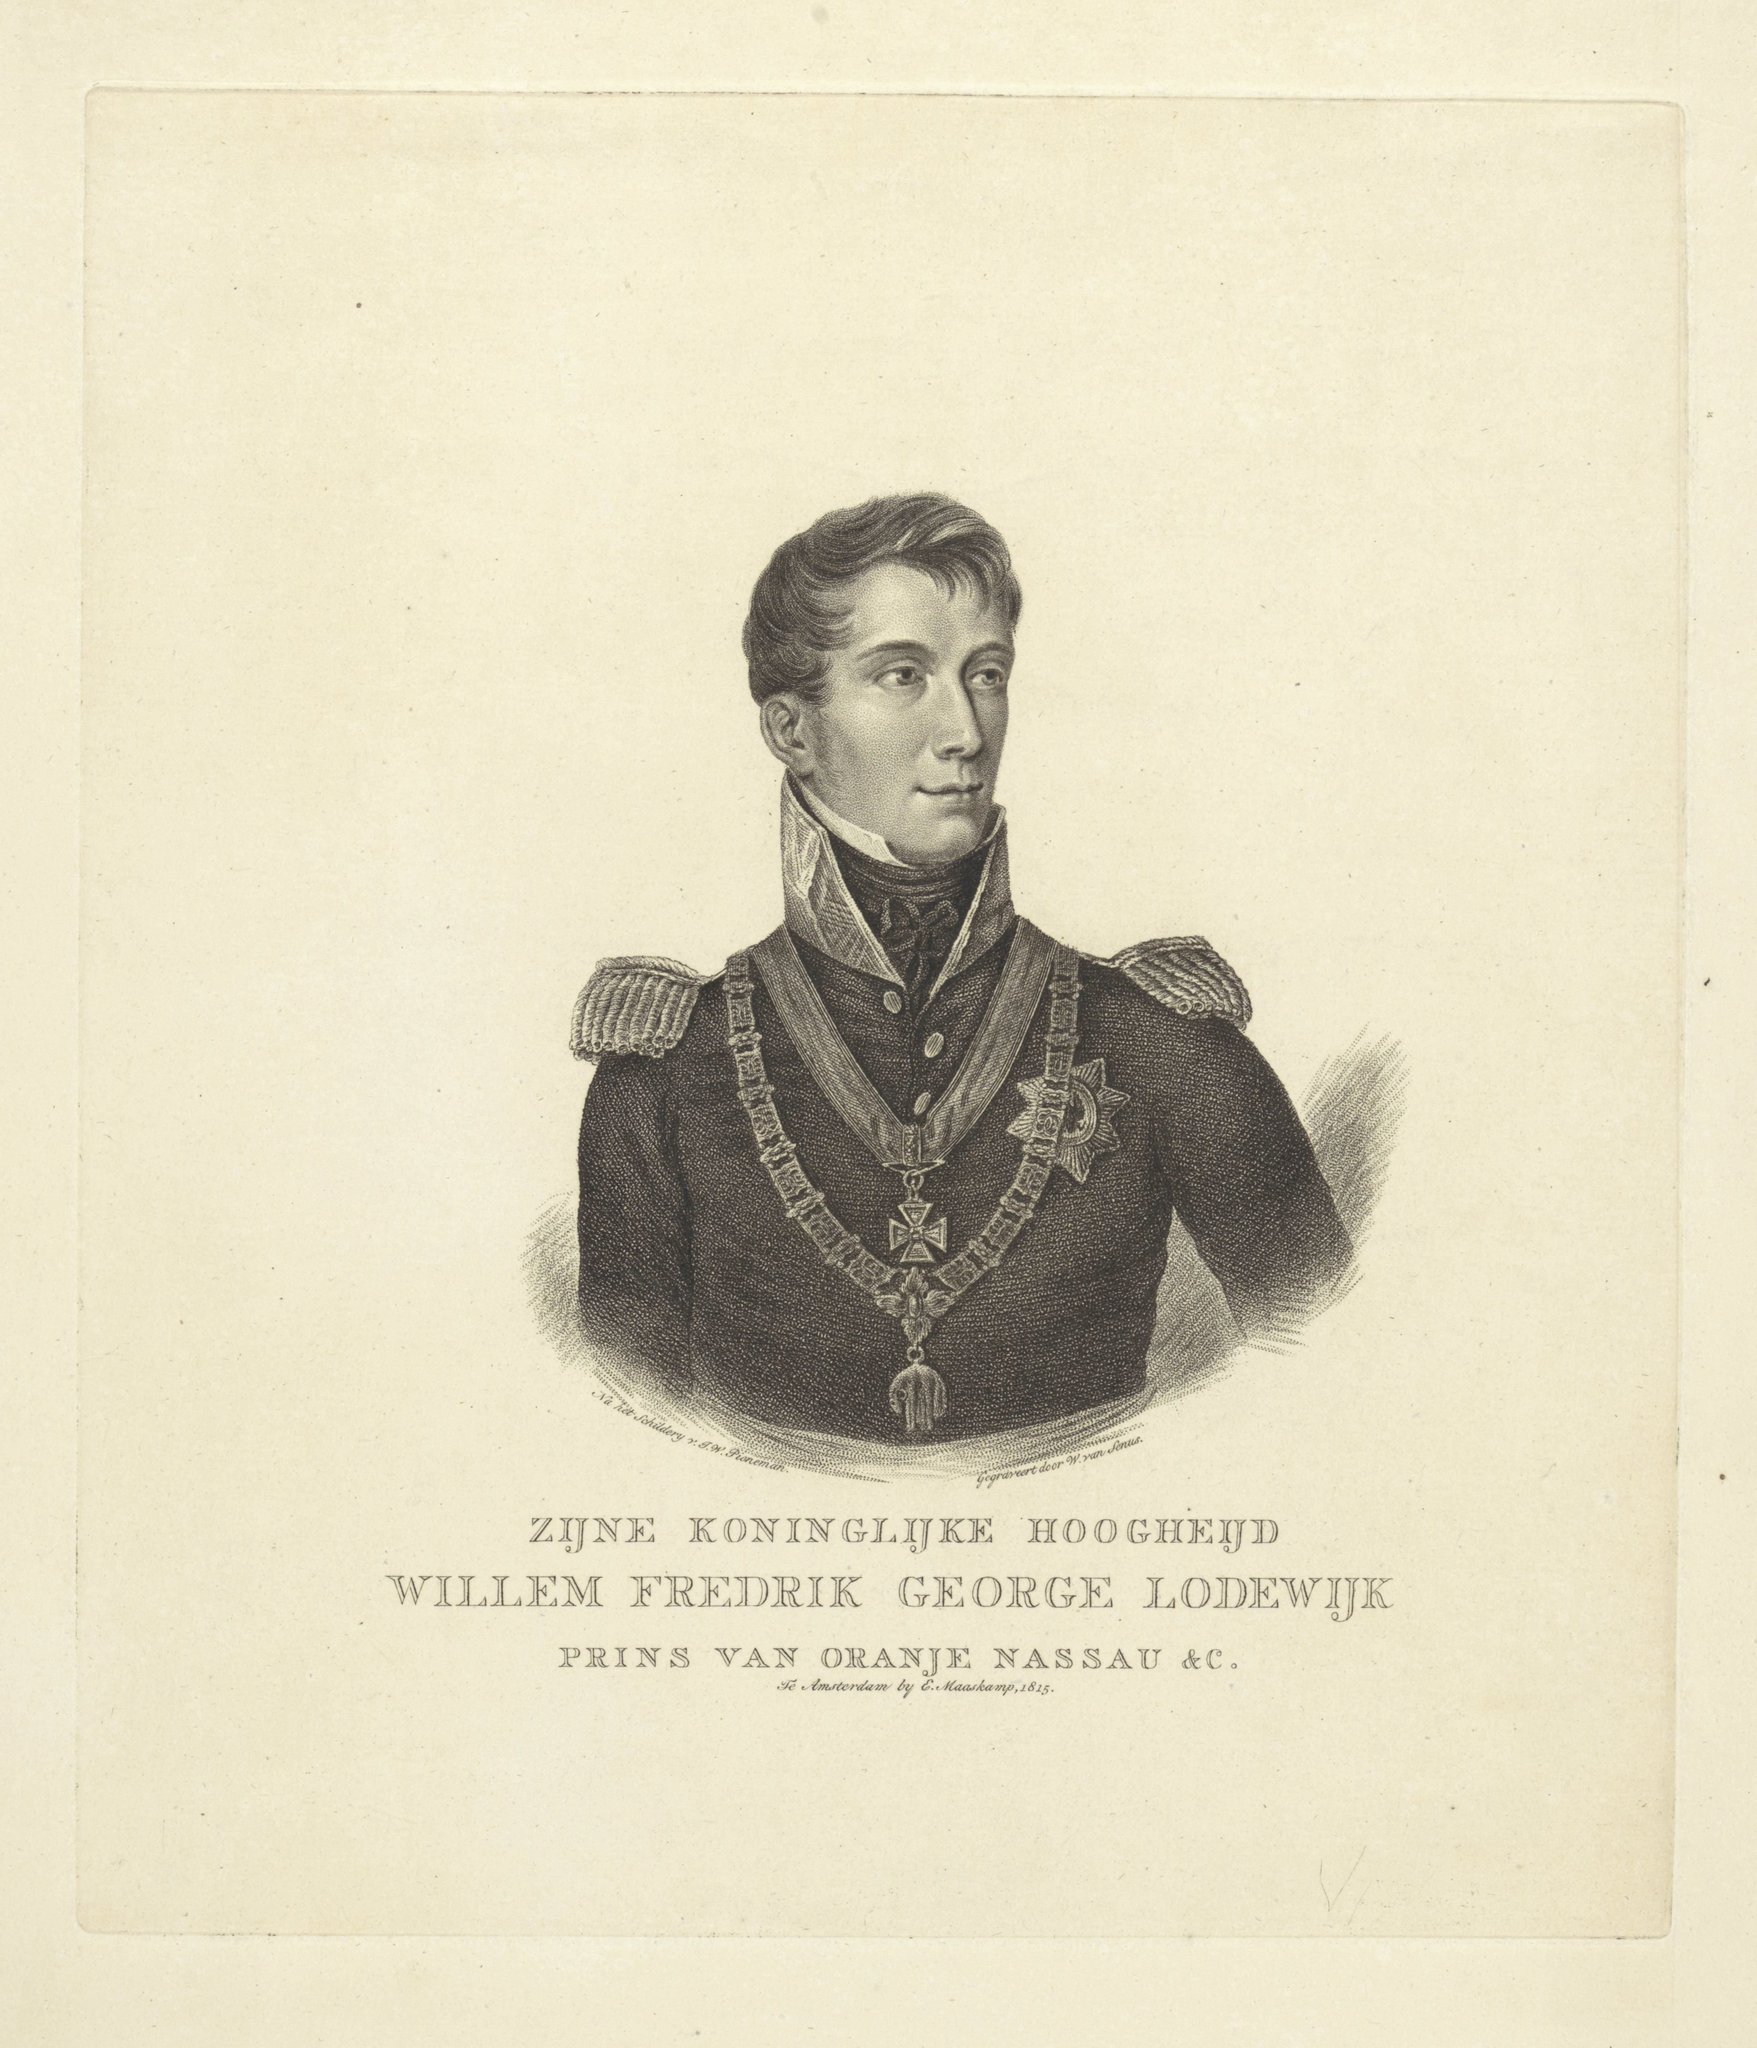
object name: print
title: Portret van Willem II (koning der Nederlanden)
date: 1815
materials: paper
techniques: engraving, etching, roulette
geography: amsterdam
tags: the hague, william ii of the netherlands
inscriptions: collector's mark: Lugt 2228